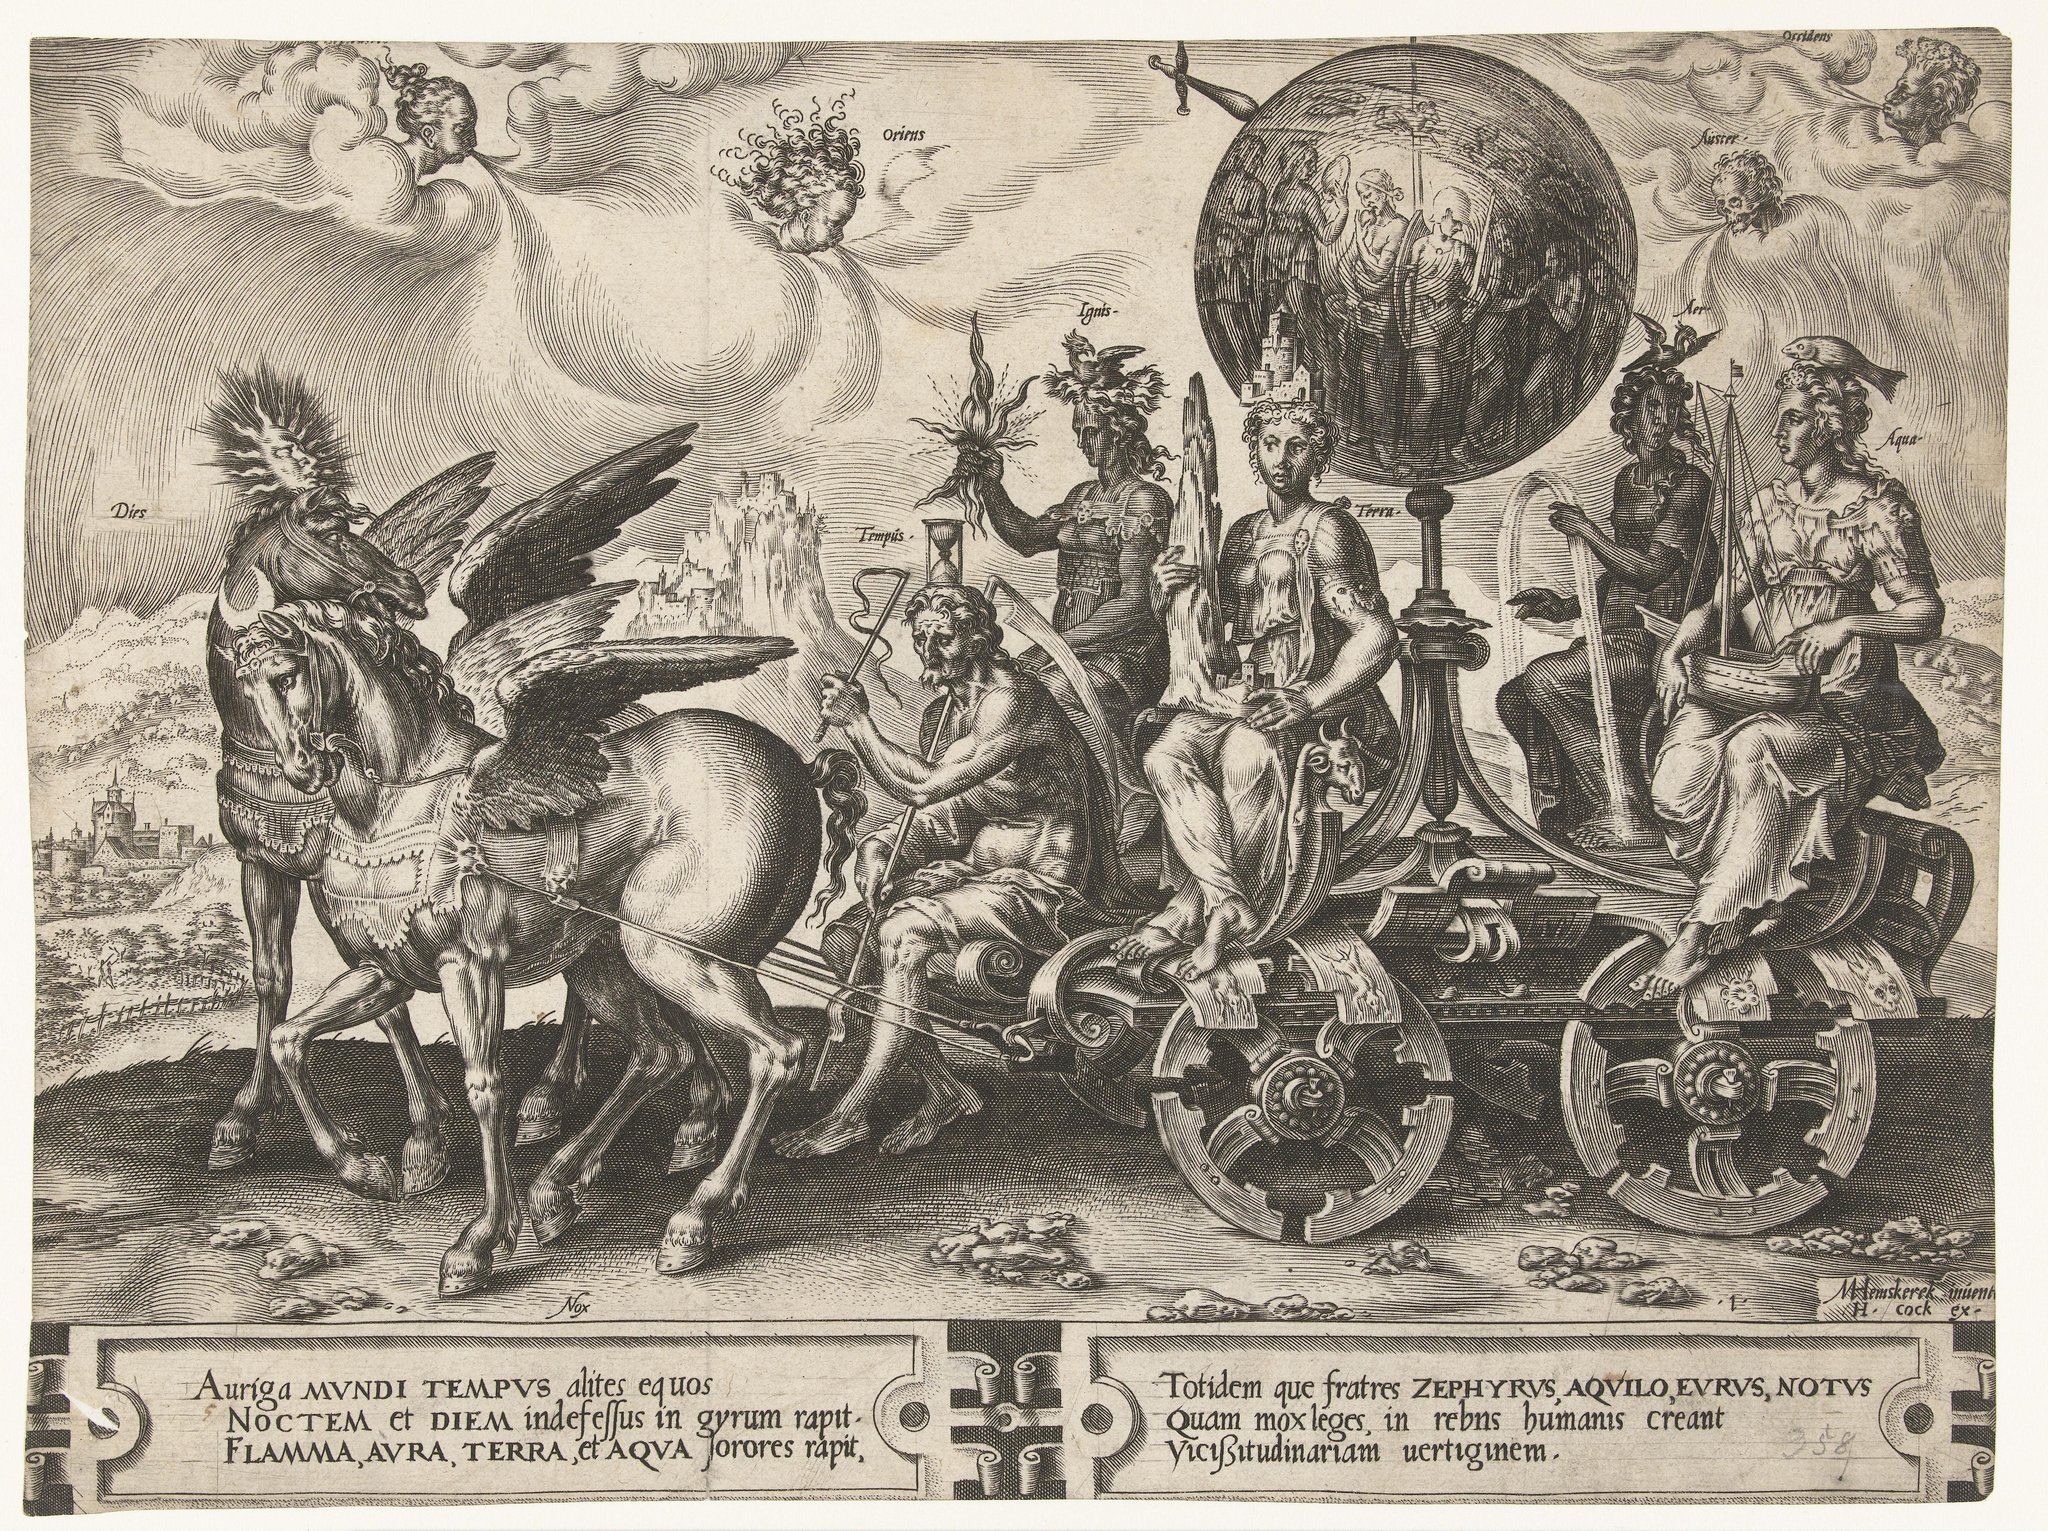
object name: print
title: Triomfwagen van de Wereld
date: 1564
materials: paper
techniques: engraving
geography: antwerp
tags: the four elements, and ether, the fifth element, vicissitudes of life (+ allegorical scene, i.e. two or more personifications involved in an action), the four main directions of the wind, 'giorno naturale', 'carro del giorno naturale' (ripa), chariot, triumphal car, personification of the night, 'nox'; 'notte', 'carro della notte', 'serenità della notte' (ripa), triumphs (allegorical and symbolic), father time, man with wings and scythe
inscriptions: number: ‘1’, signature: ‘MHemskerck invento’, caption: ‘Auriga MUNDI... Vicissitudinariam vertiginem’, collector's mark: Lugt 2228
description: Triomfwagen met gebroken wielen, getrokken door twee gevleugelde paarden. Het rechterpaard heeft de zon op zijn hoofd en stelt de dag (Dies) voor; het linker paard is de nacht (Nox) en heeft een maansikkel op het hoofd. De wagen wordt gemend door de Tijd als oude man met zeis en zandloper. Op de vier hoeken van de kar zitten de personificaties van de vier elementen: Ignis, Terra , Aer en Aqua met hun attributen. In het midden op een standaard staat de wereldbol. In de wolken blazen de vier winden. Prent uit een serie van negen prenten met triomfwagens uit de Antwerpse Besnijdenis-ommegang van 1561.